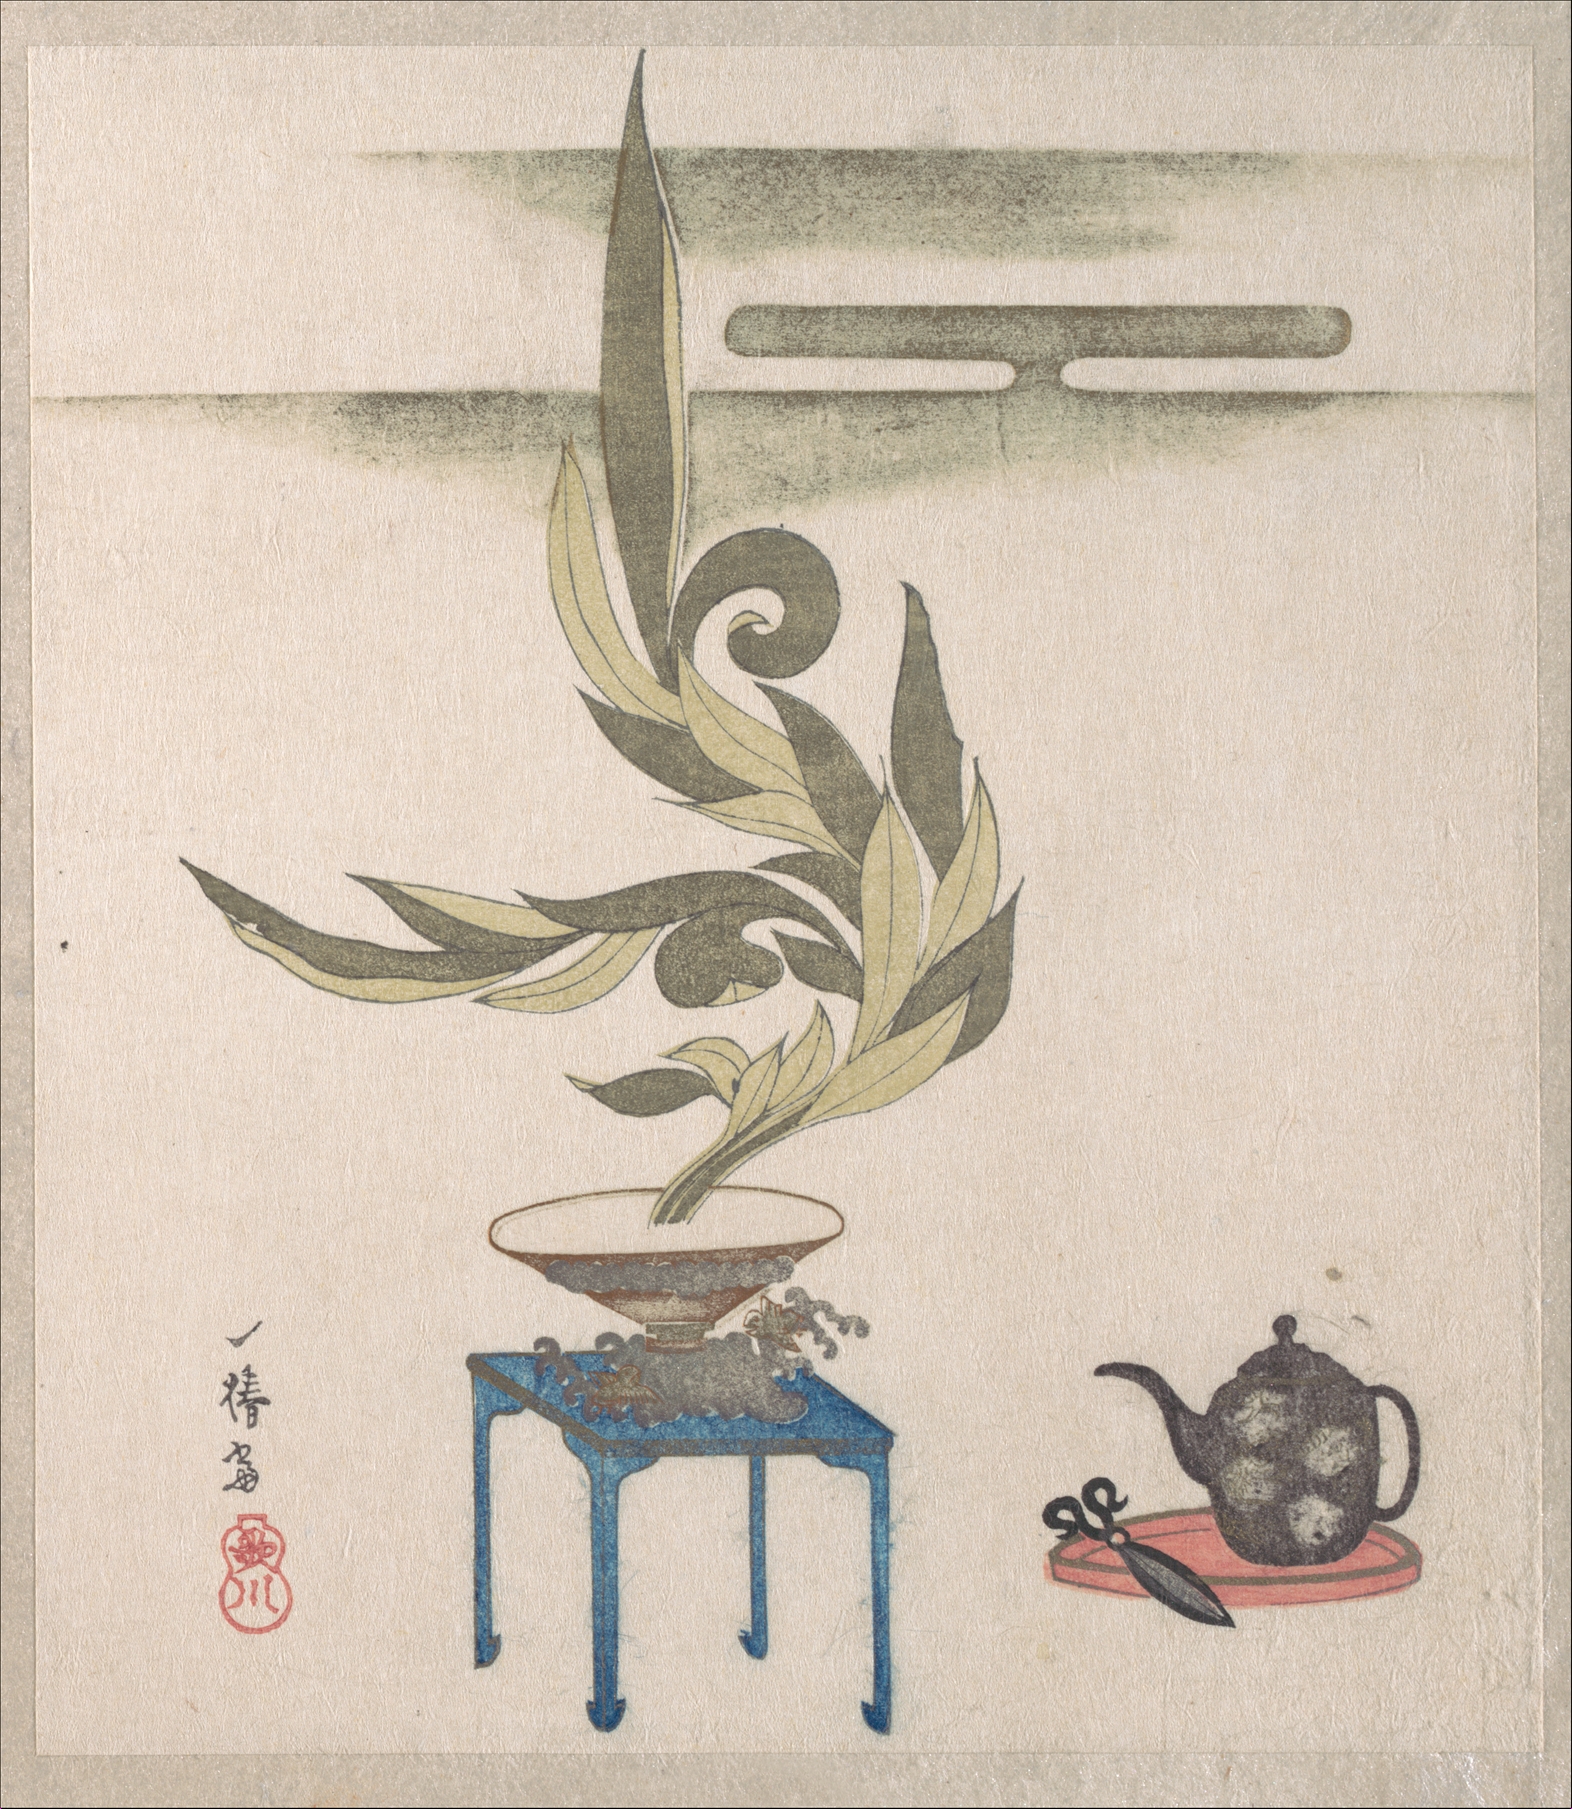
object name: print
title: Flower Arrangement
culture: japanese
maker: utagawa itchinsai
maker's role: artist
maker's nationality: japanese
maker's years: 1700-1900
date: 1801-1900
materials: ink, paper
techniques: surimono, woodblock print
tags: plants